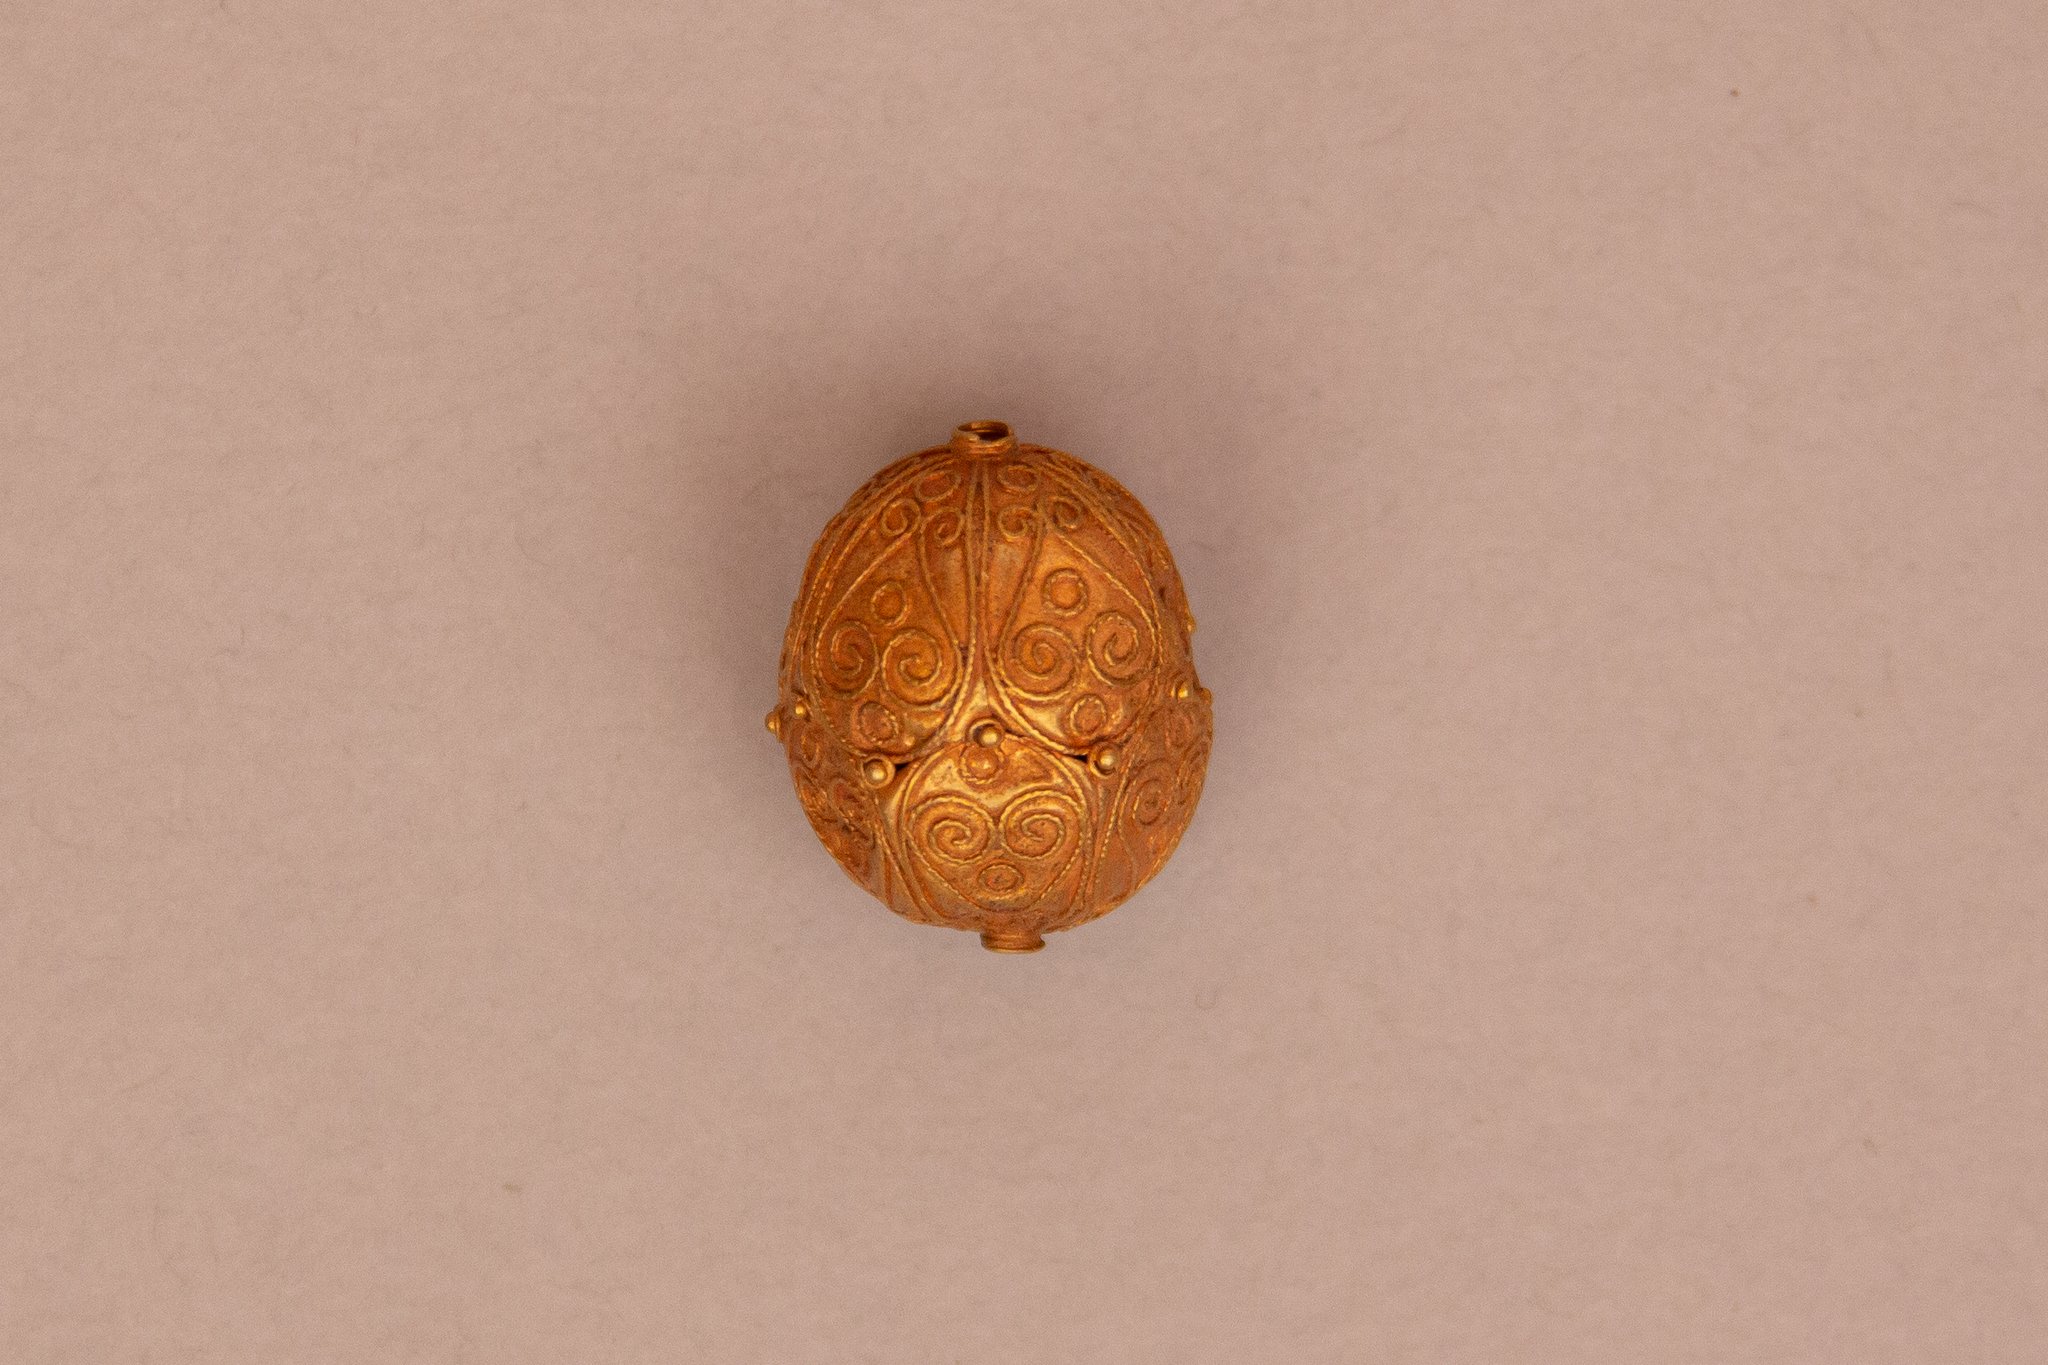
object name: bead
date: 1001-1100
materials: gold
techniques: filigree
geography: egypt or syria